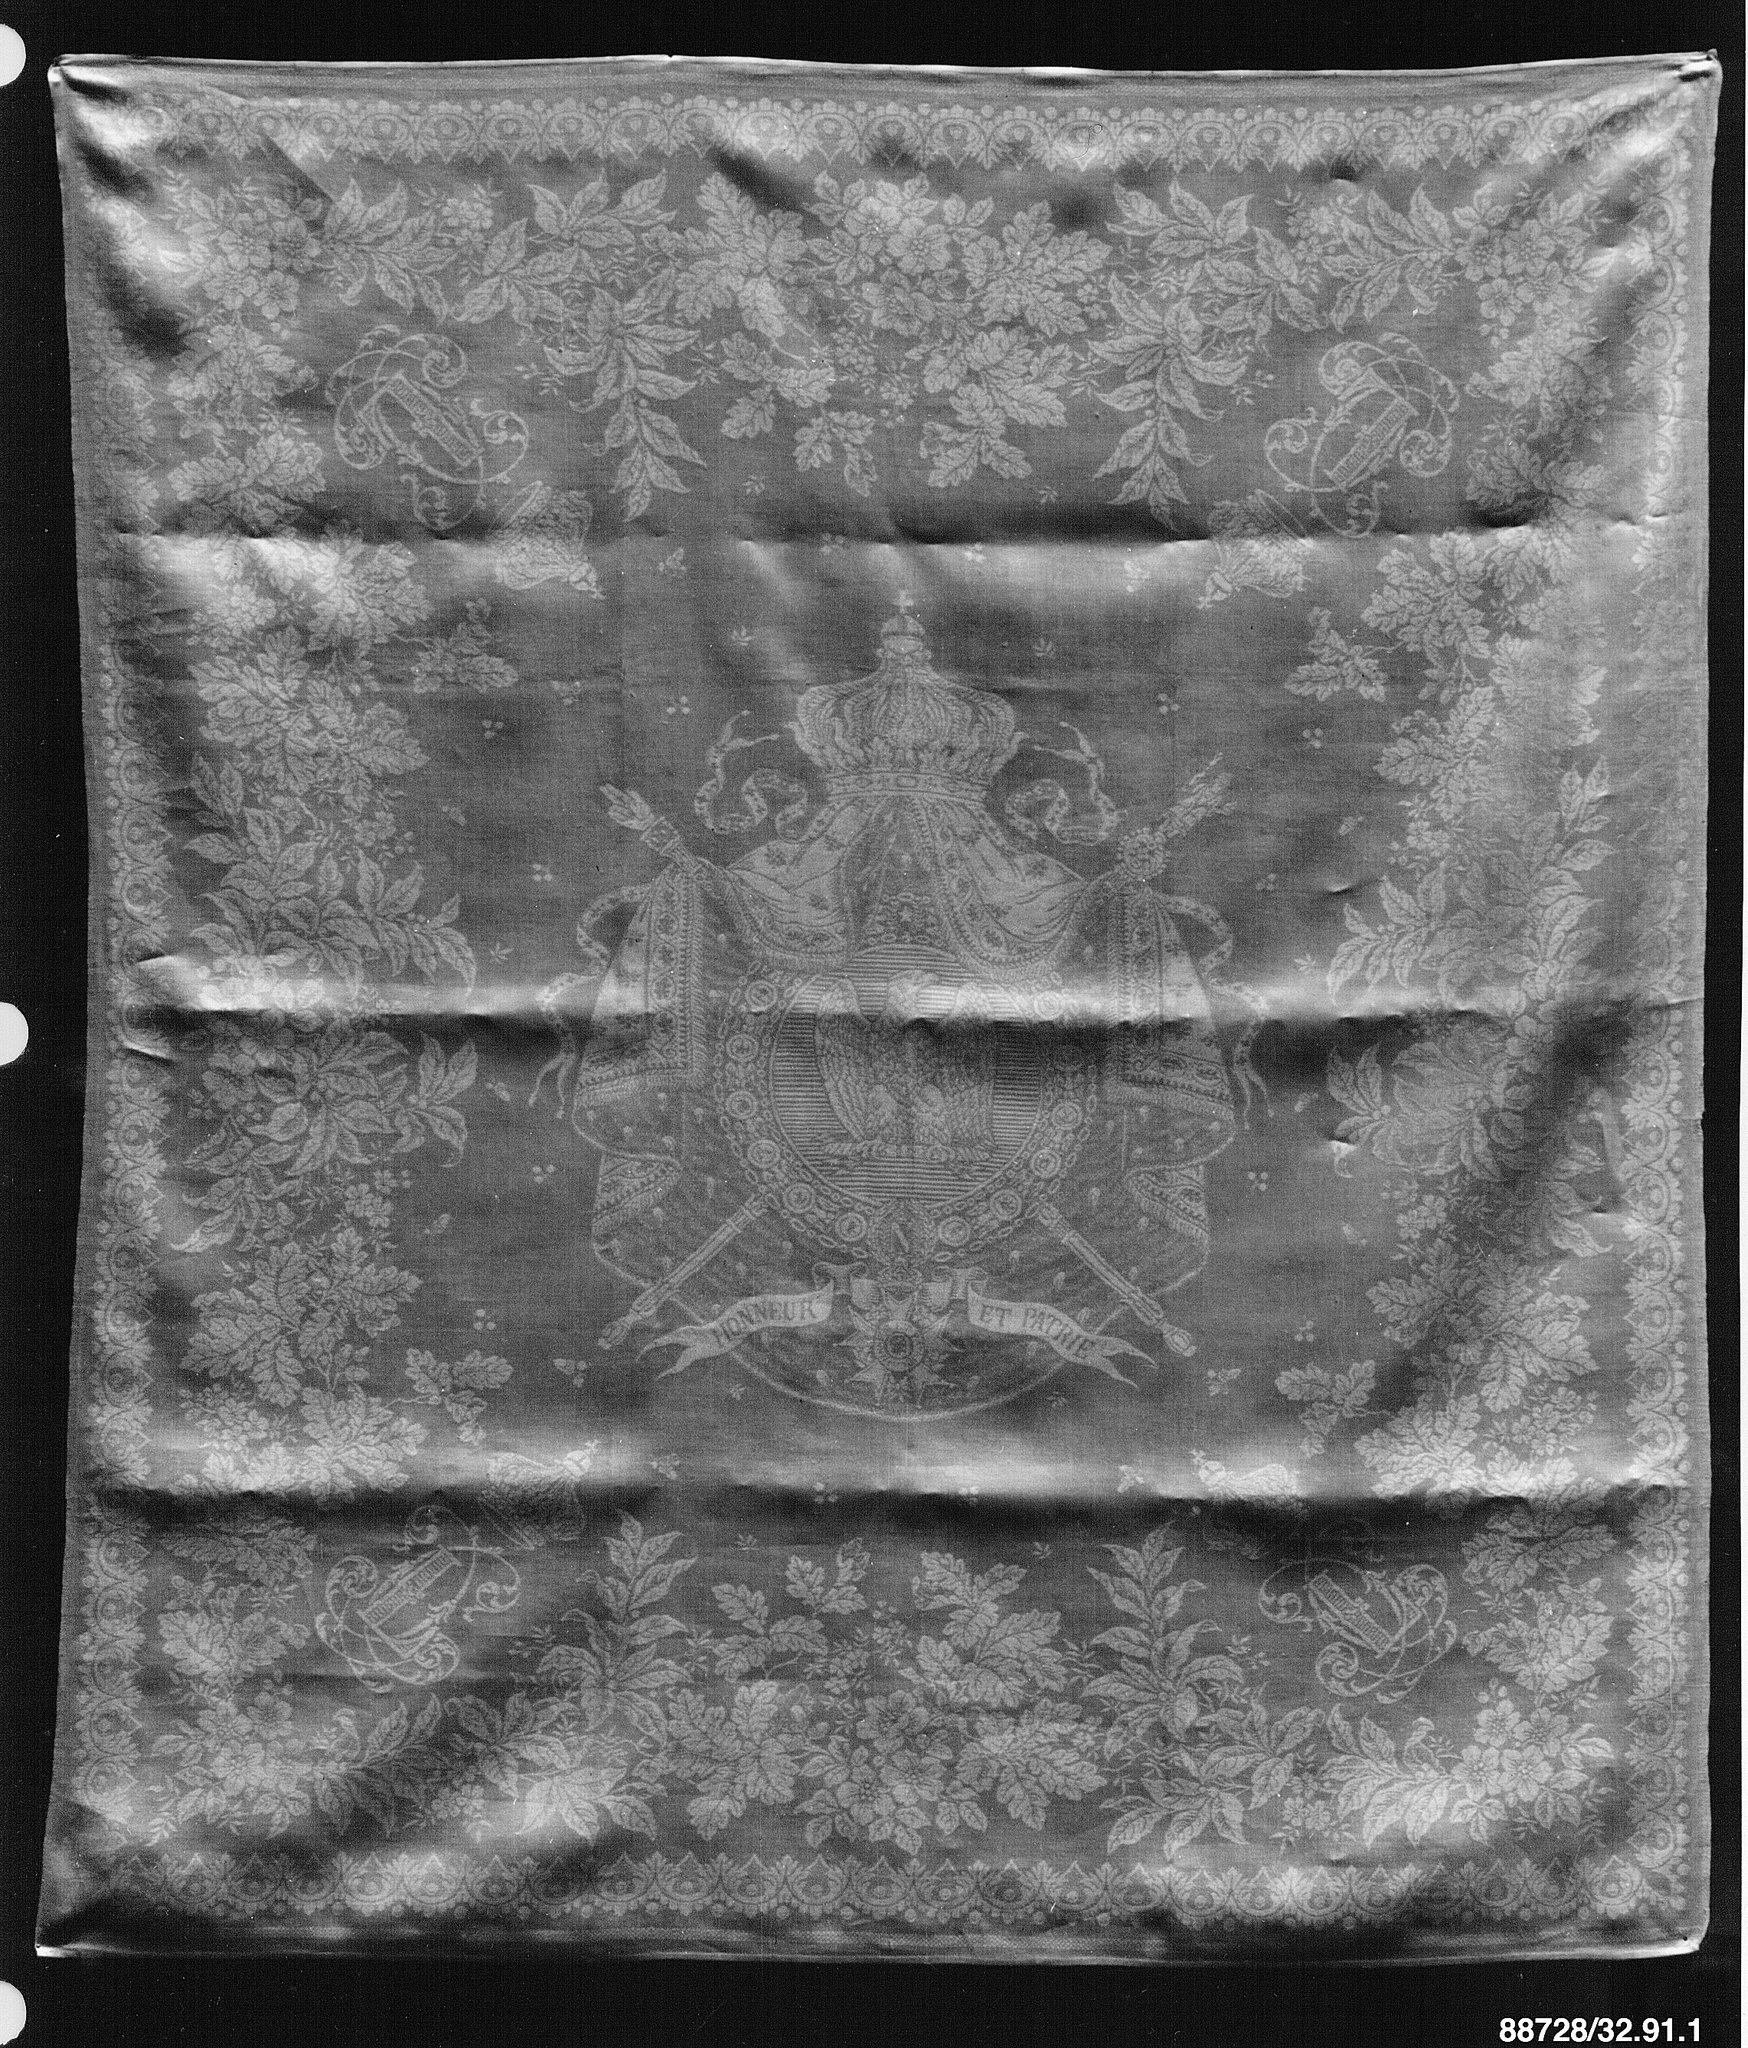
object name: napkin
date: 1848-1852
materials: linen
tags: eagles,flowers,coat of arms